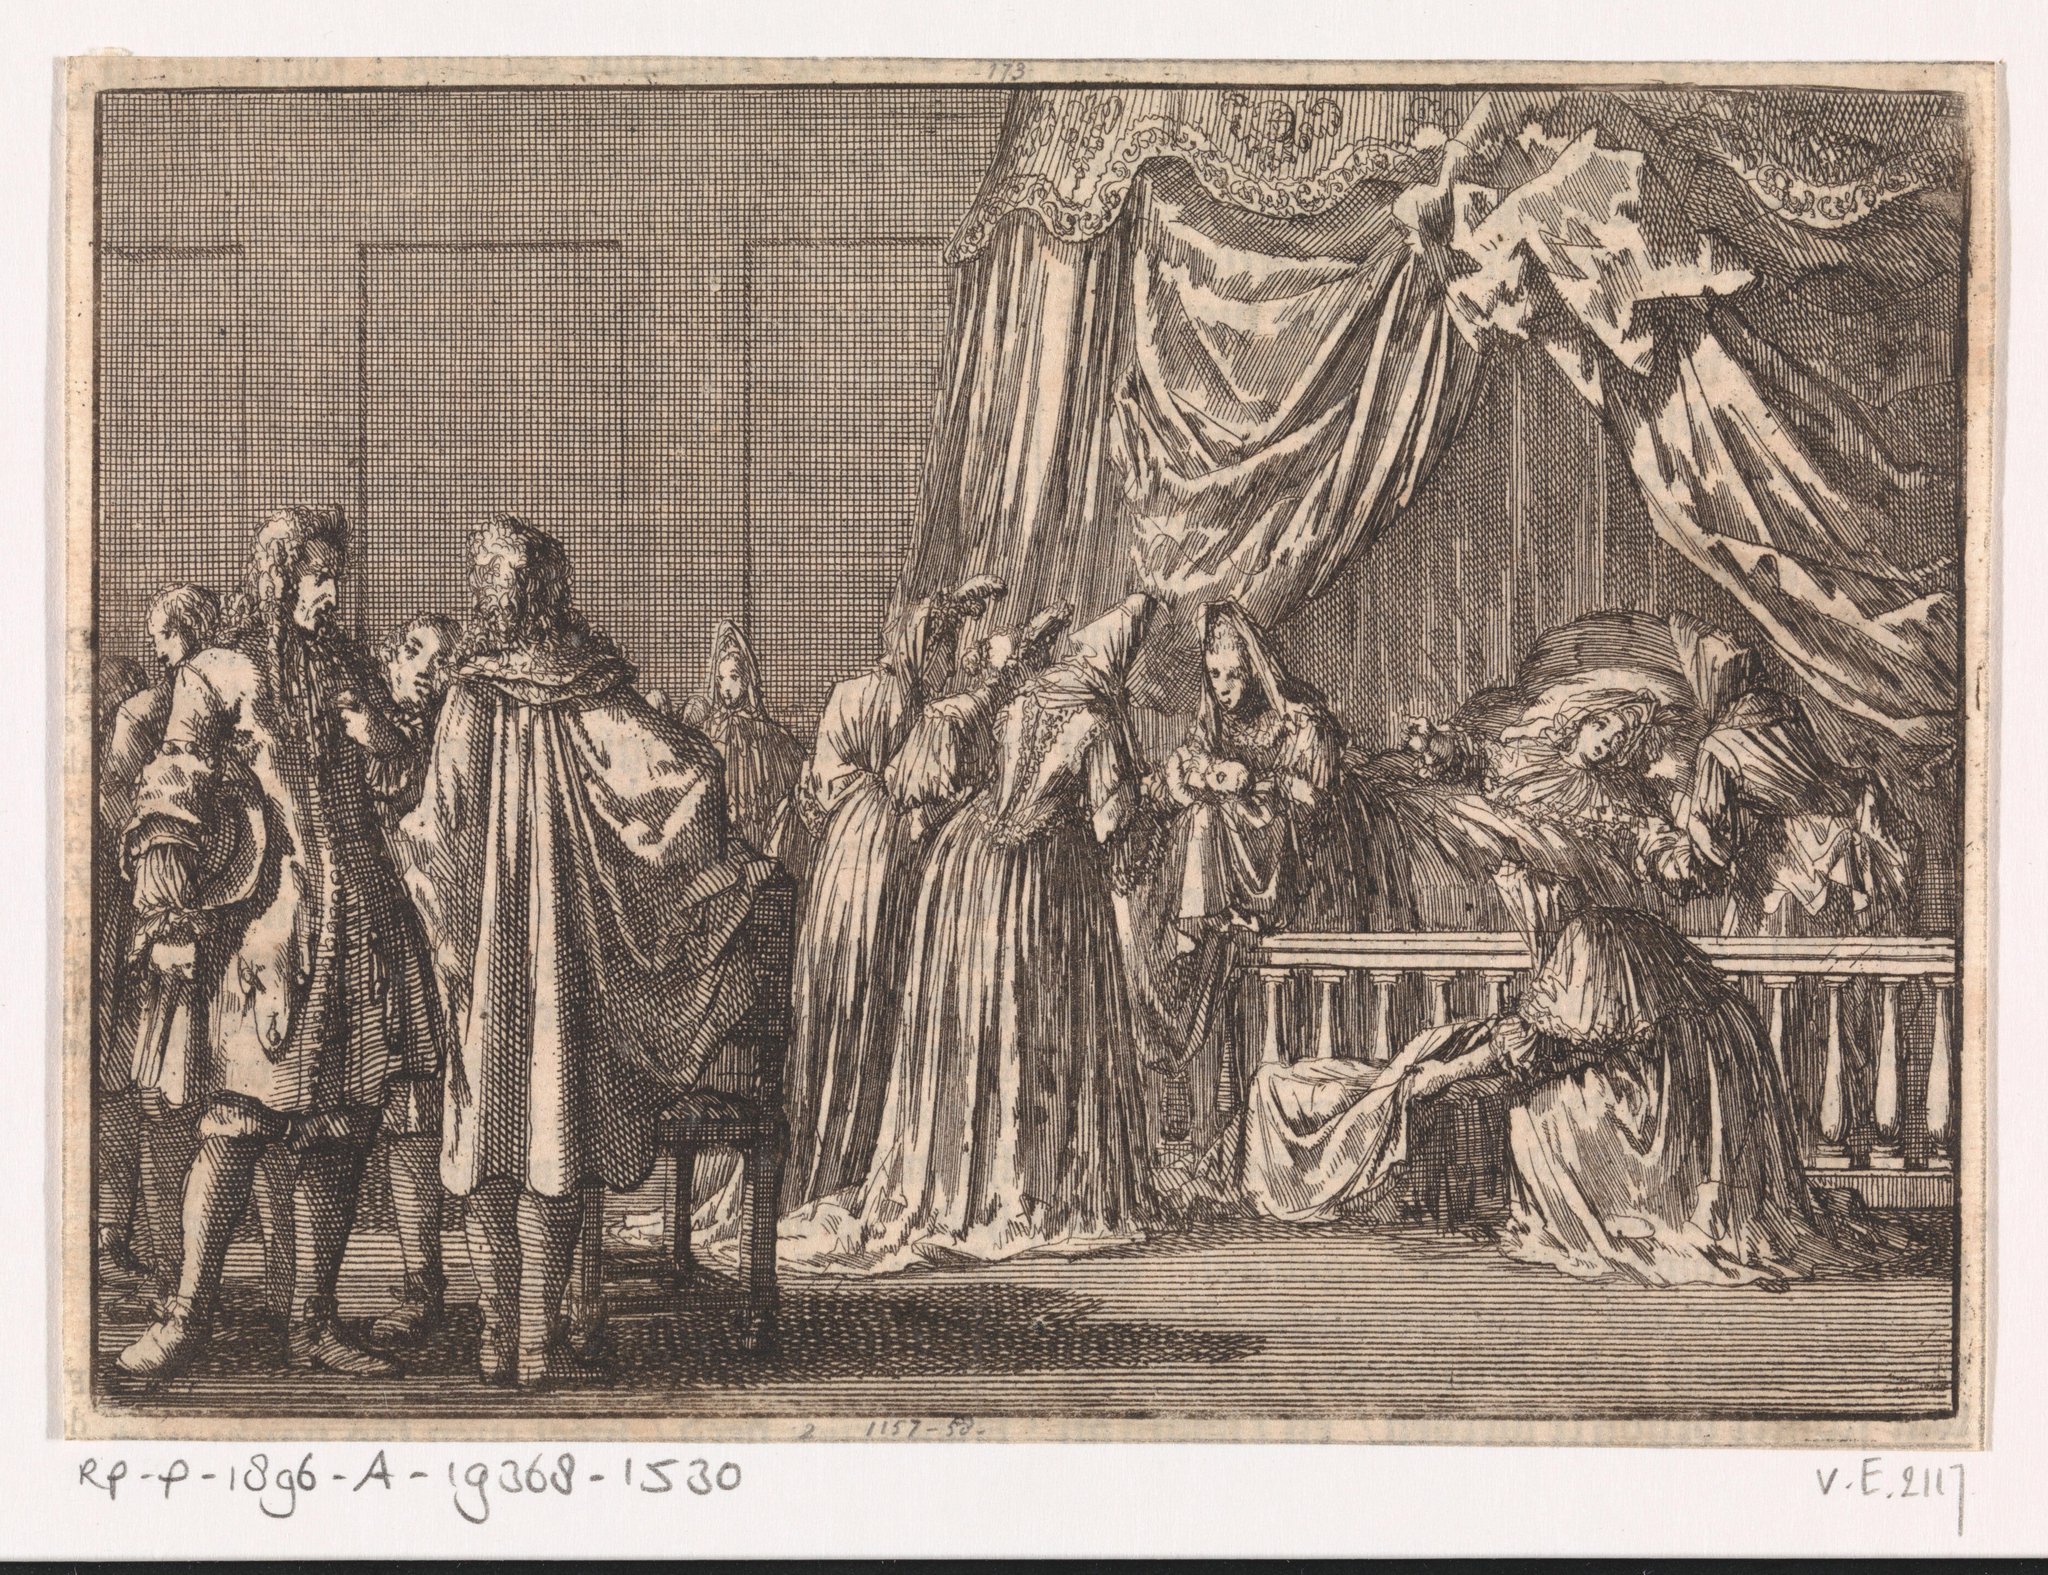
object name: book illustration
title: Geboorte van de zoon van koning Jacobus II van Engeland, 1688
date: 1698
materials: paper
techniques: etching, letterpress printing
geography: amsterdam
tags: jacobus ii (koning van engeland en schotland), london, confinement, birth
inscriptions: collector's mark: Lugt 2228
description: Illustratie uit: Gottfried, Johann Ludwig. Historische kronyck; vervattende een (...) beschrijvingh der aldergedenckwaerdigste geschiedenissen des weerelds, van den aenvangh der scheppingh tot (...) 1576 (2 delen). Leiden: Pieter van der Aa, 1698, dl. II, p. 1143.